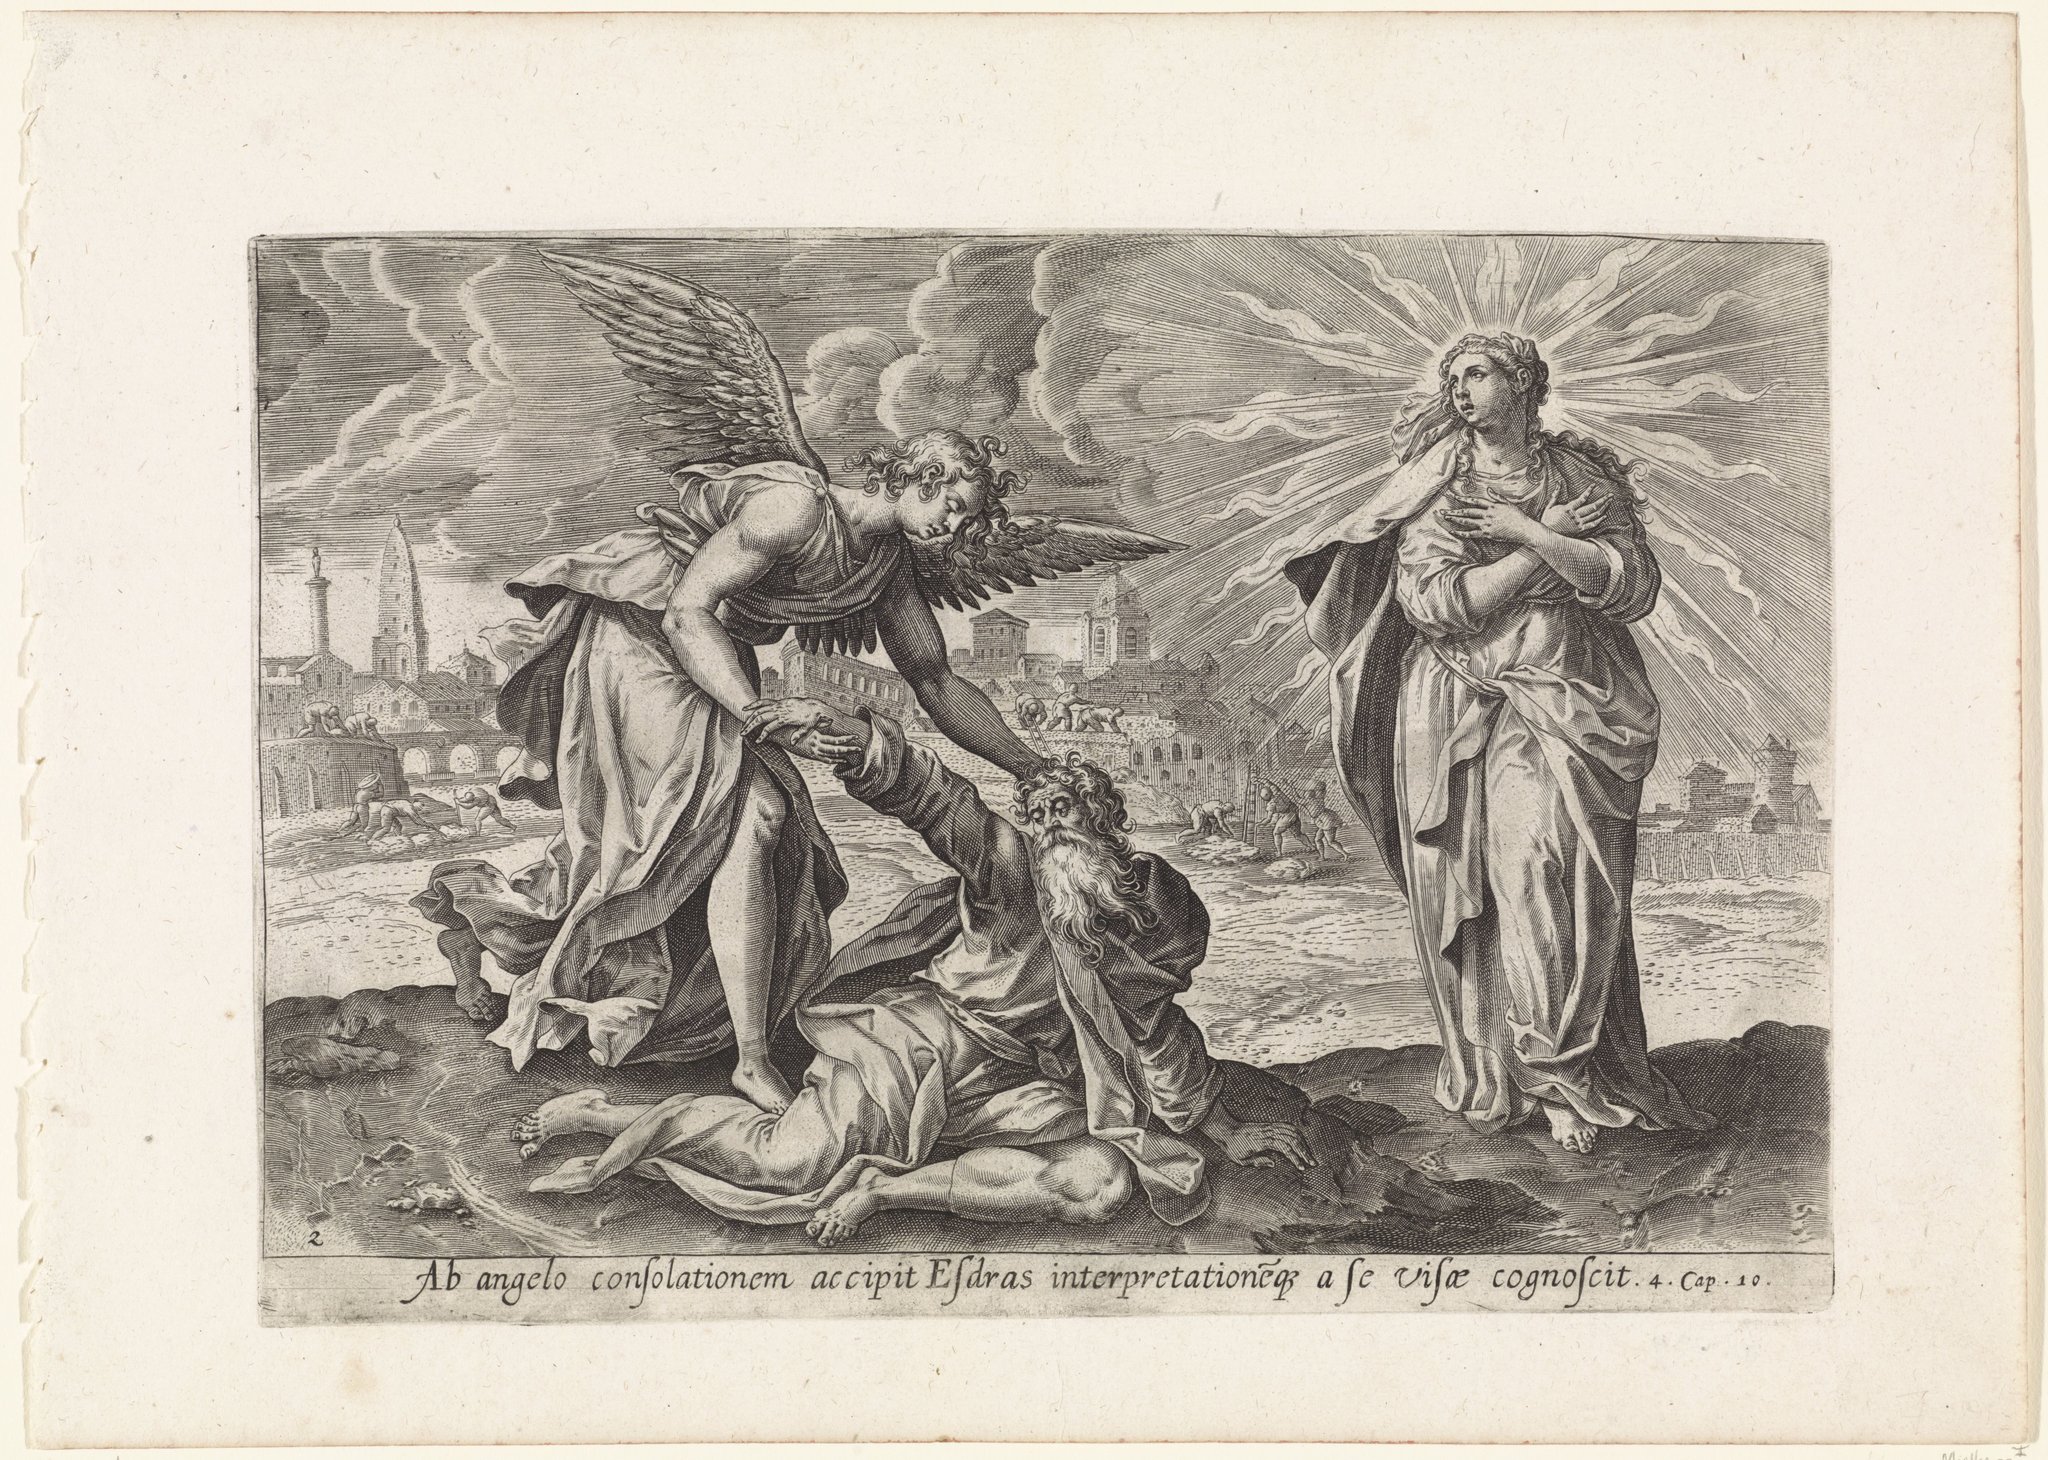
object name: print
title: Tweede visioen van Ezra: Ezra getroost door de engel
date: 1585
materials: paper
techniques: engraving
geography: antwerp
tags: ezra commanded to write prophecies (2 esdras 15:1-2)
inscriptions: collector's mark: Lugt 2228, collector's mark: Lugt 2760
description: De engel Uriël troost Ezra en helpt hem overeind. Naast Ezra zijn visioen van de stralende vrouw Sion. Als zij verdwijnt ziet Ezra de stad die wordt gebouwd op de achtergrond. Onder de voorstelling een verwijzing in het Latijn naar de apocriefe Bijbeltekst in 4 Ezra 10.